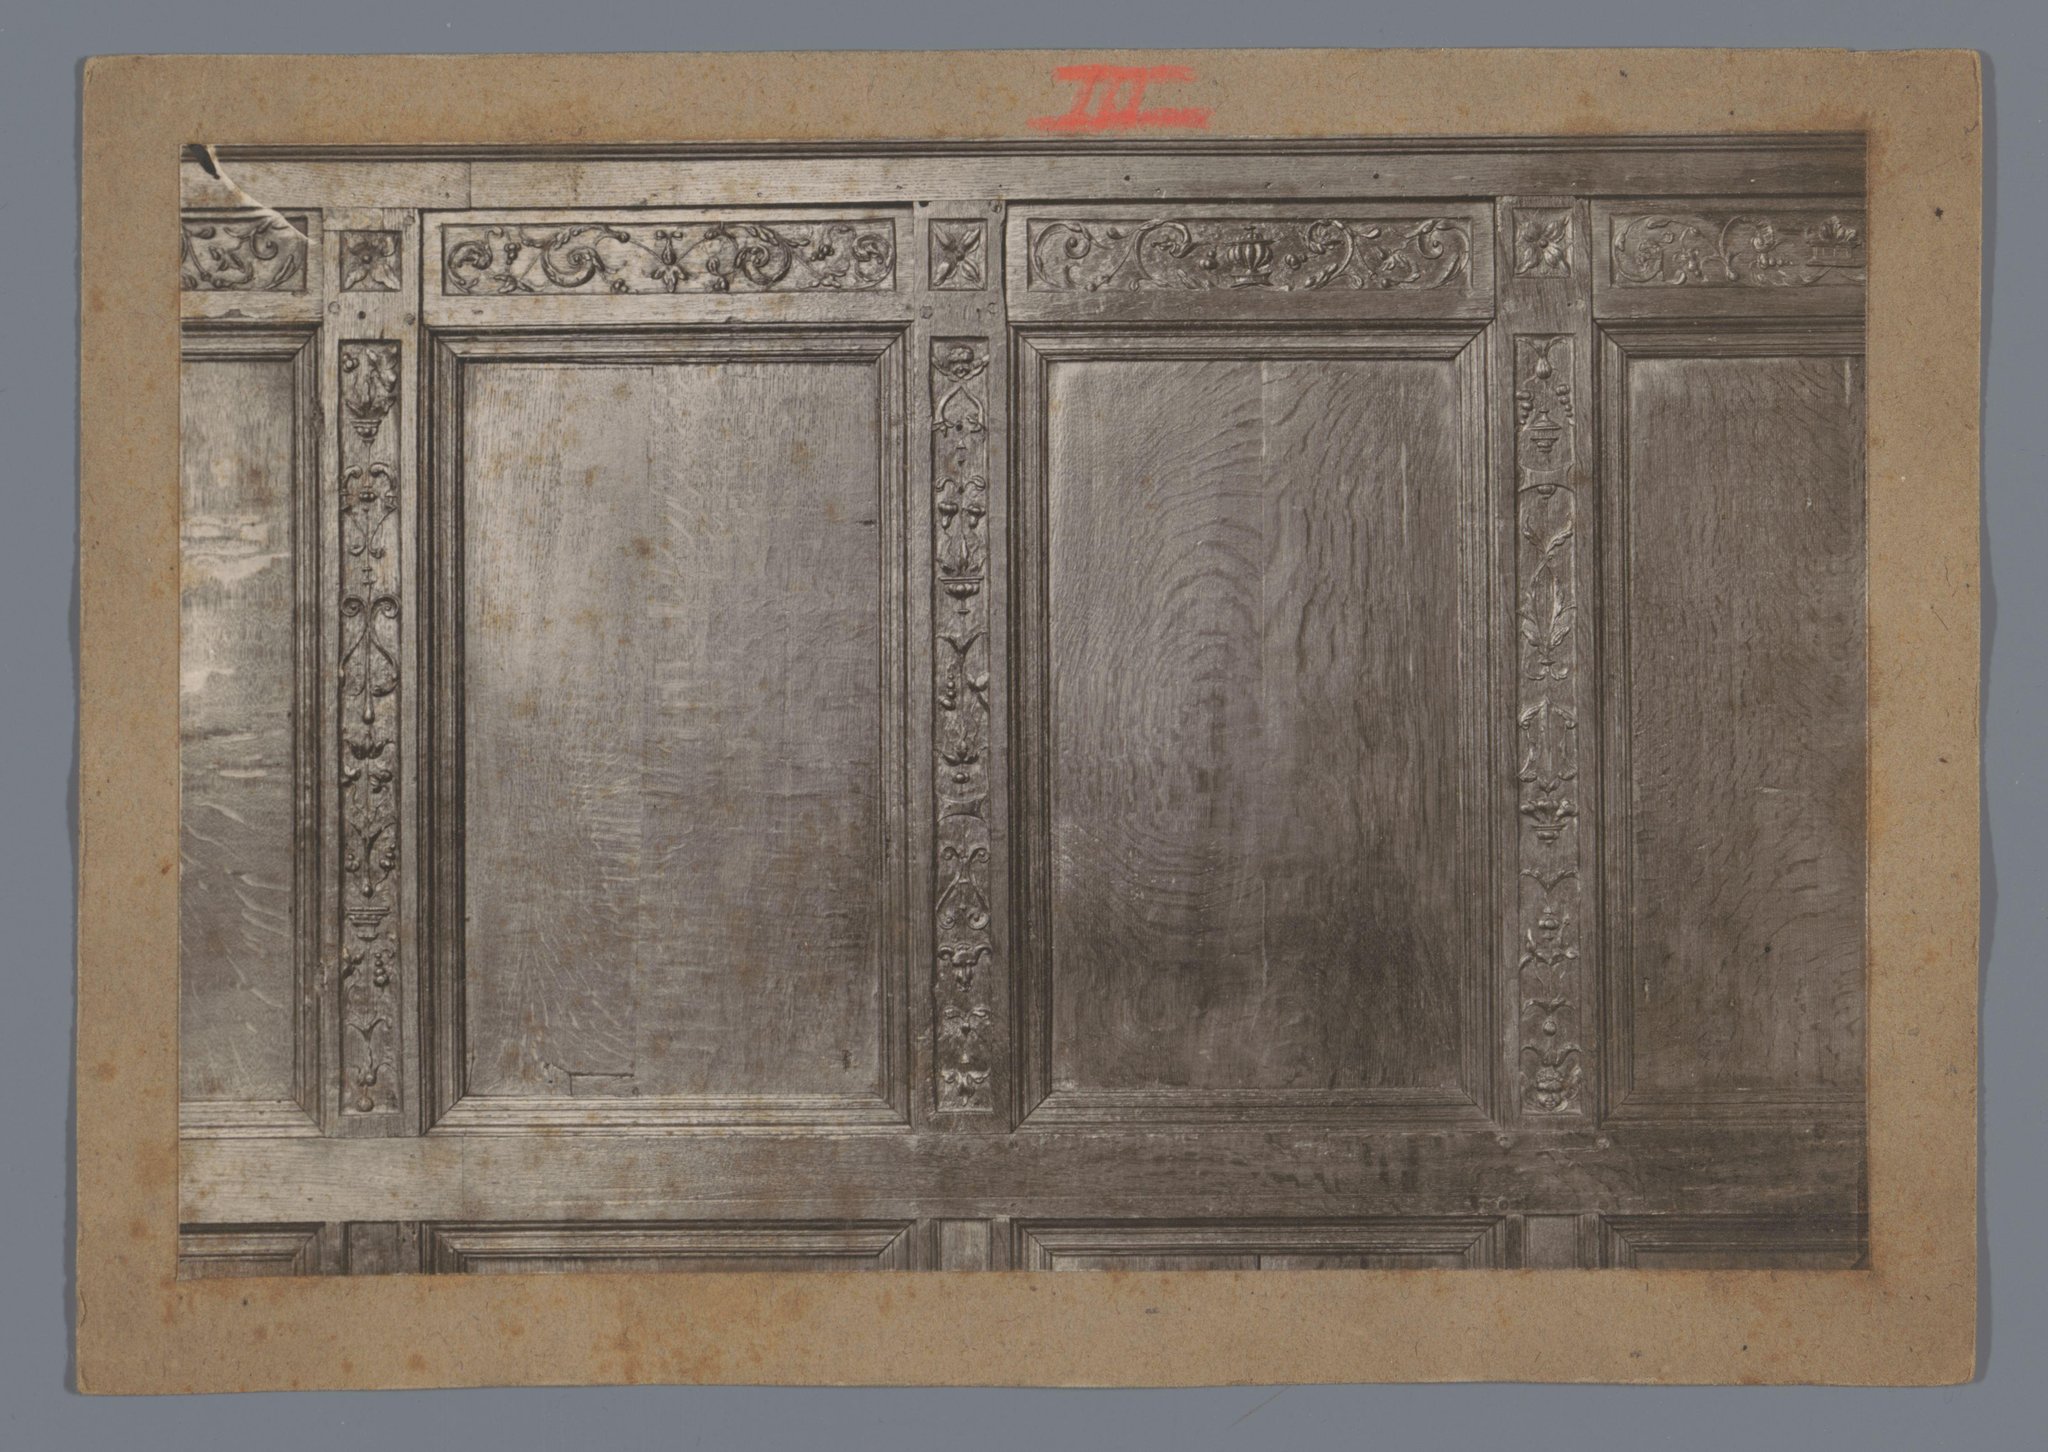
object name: photograph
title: Houten paneel, vermoedelijk een wandbetimmering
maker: Anonymous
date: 1875-1900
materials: photographic support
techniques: matte daylight collodion silver print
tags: wall-covering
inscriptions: number: ‘III’, collector's mark: ‘Instituut voor kunst-nijverheidsonderwijs Gabriël Metsustraat No. 16, Amsterdam’